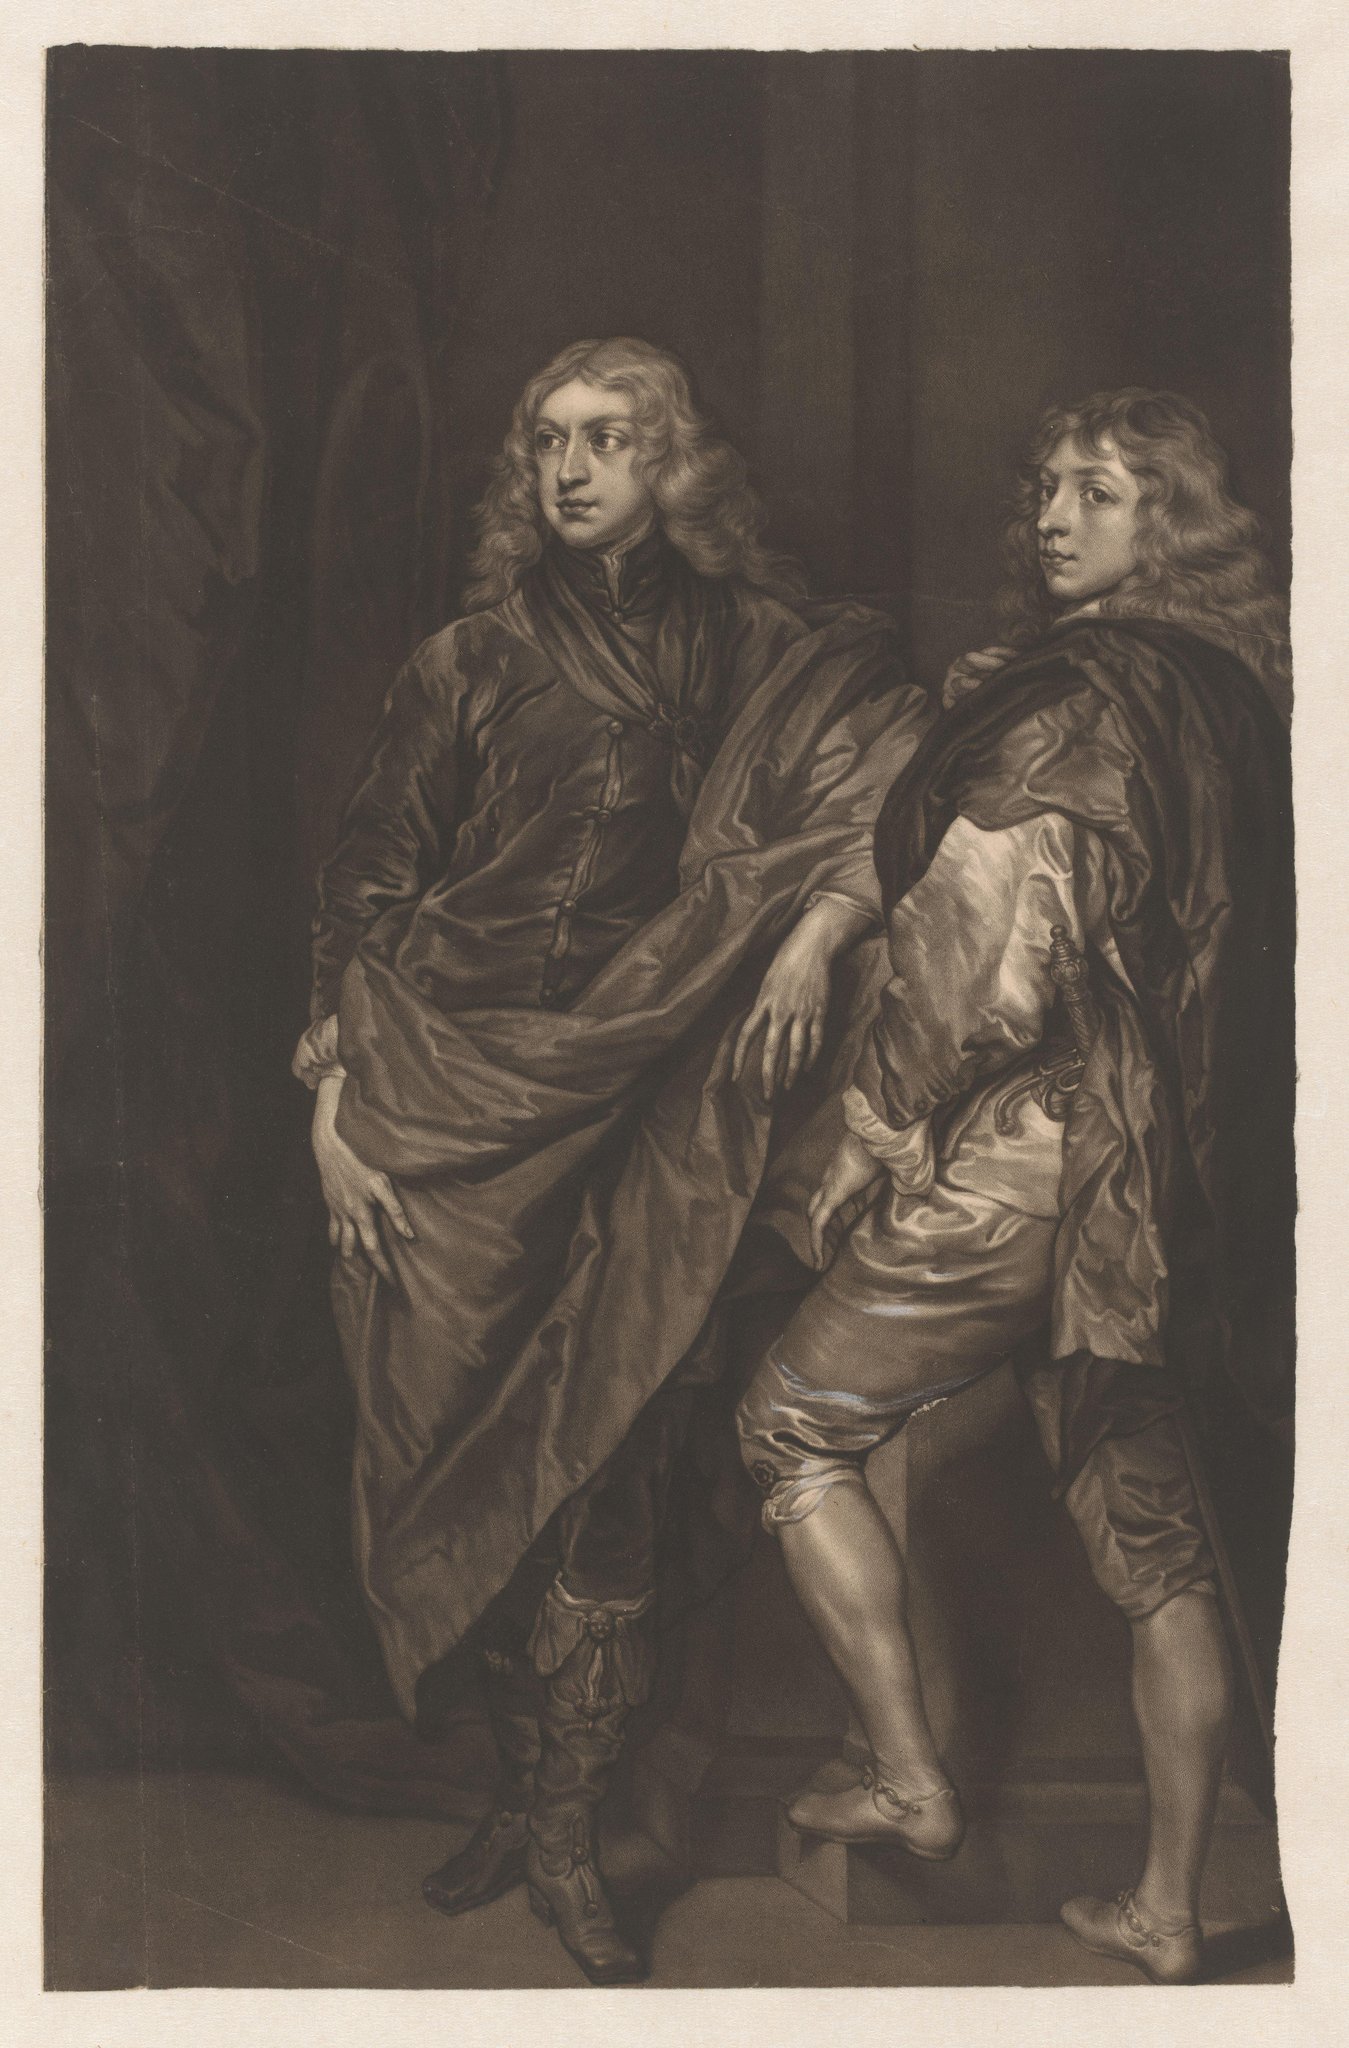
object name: print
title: Portret van John en Bernard Stuart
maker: james mcardell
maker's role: print maker, publisher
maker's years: 1728-1765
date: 1745-1765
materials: paint, paper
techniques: brush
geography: london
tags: historical person in a double portrait